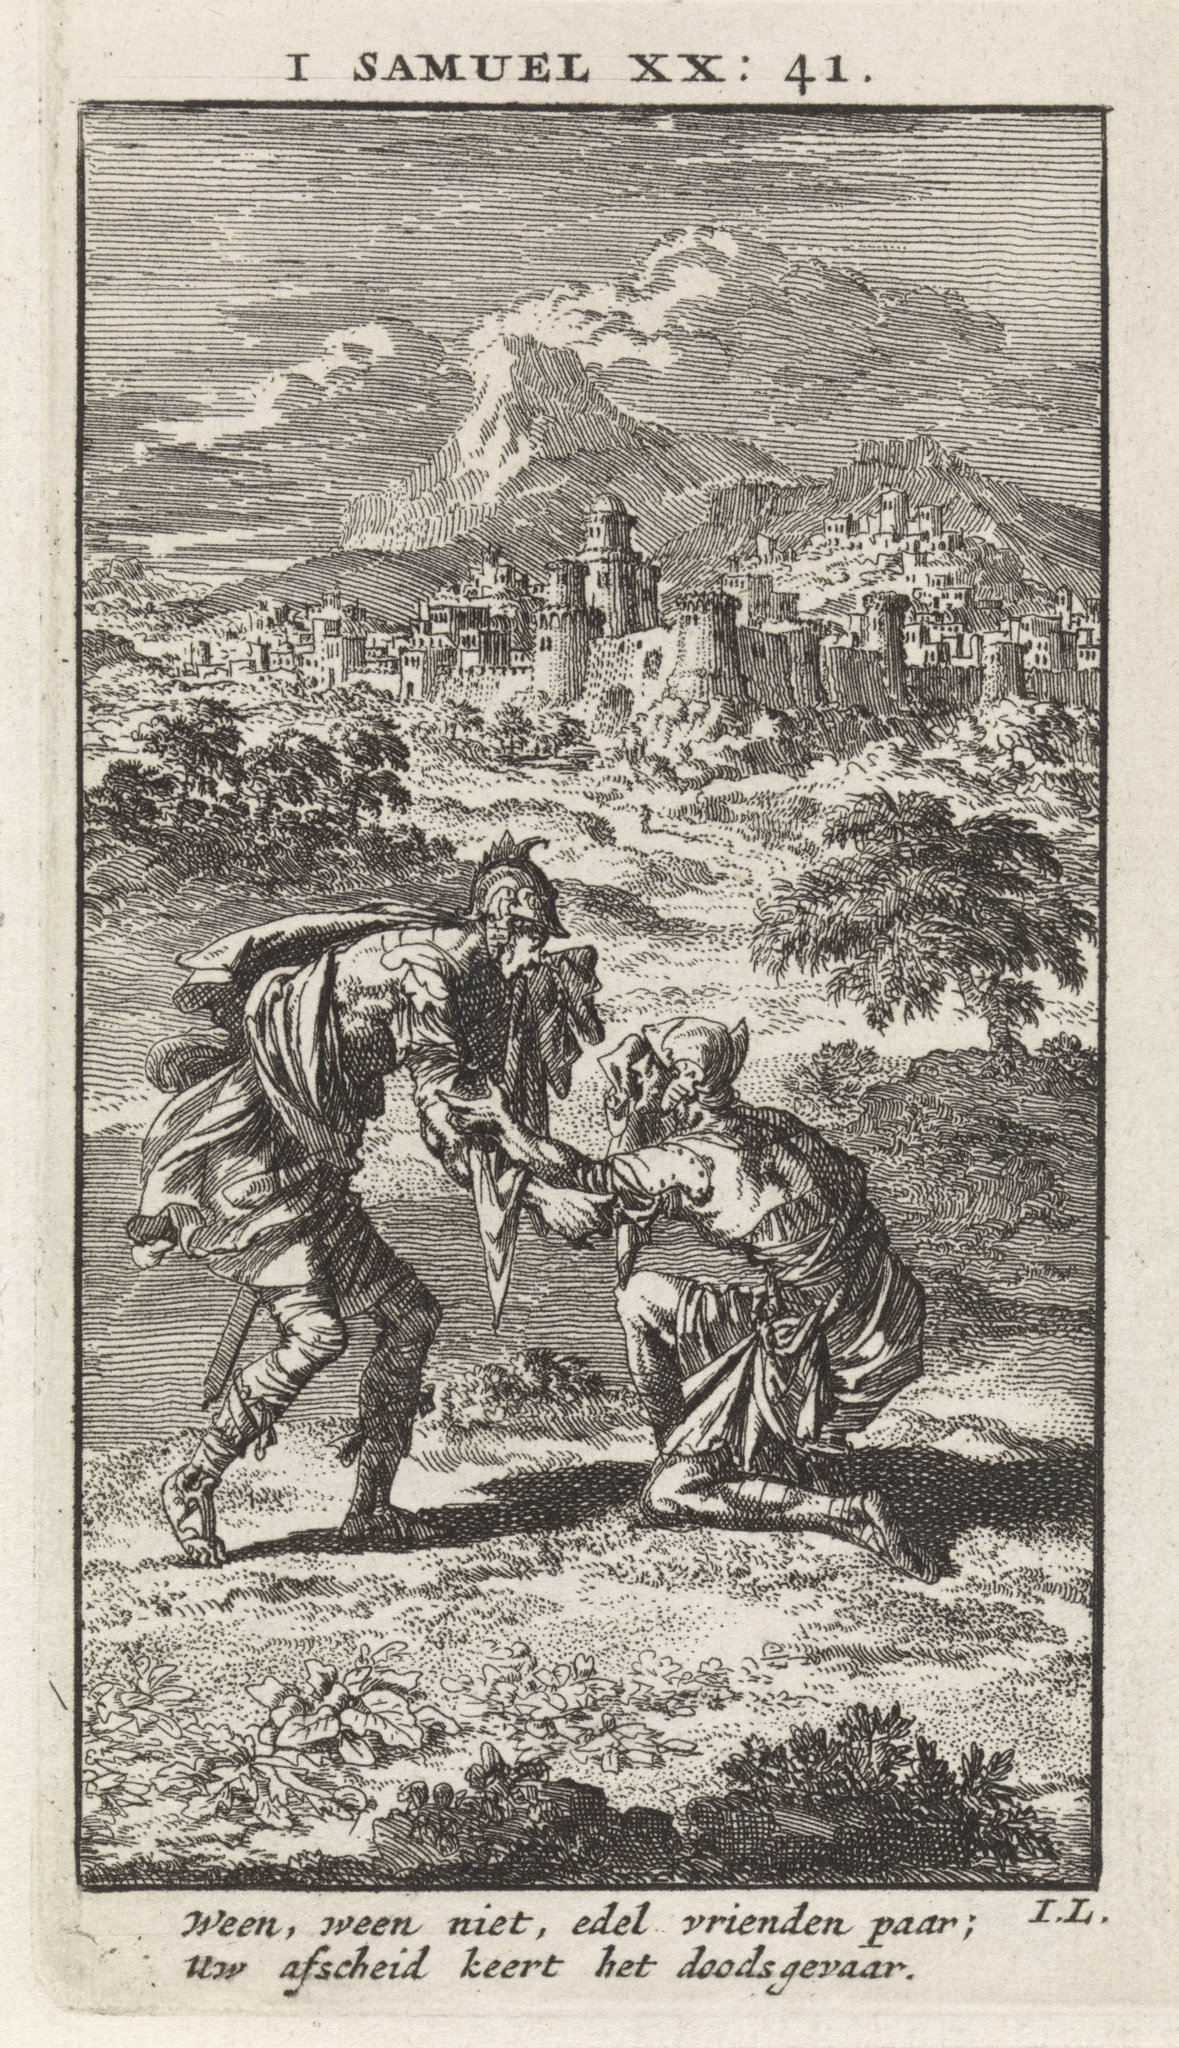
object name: print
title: Afscheid van David en Jonathan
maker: jan luyken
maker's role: draughtsman, print maker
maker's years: 1649-1712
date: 1712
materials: paper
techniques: etching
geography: amsterdam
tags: david and jonathan embracing; david's leave-taking from jonathan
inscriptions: collector's mark: Lugt 2228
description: Illustratie voor: Luyken, Jan. Bybel printen. Amsterdam: Pieter Arentsz. II (wed.) en Cornelis van der Sys, 1712, p. 11.